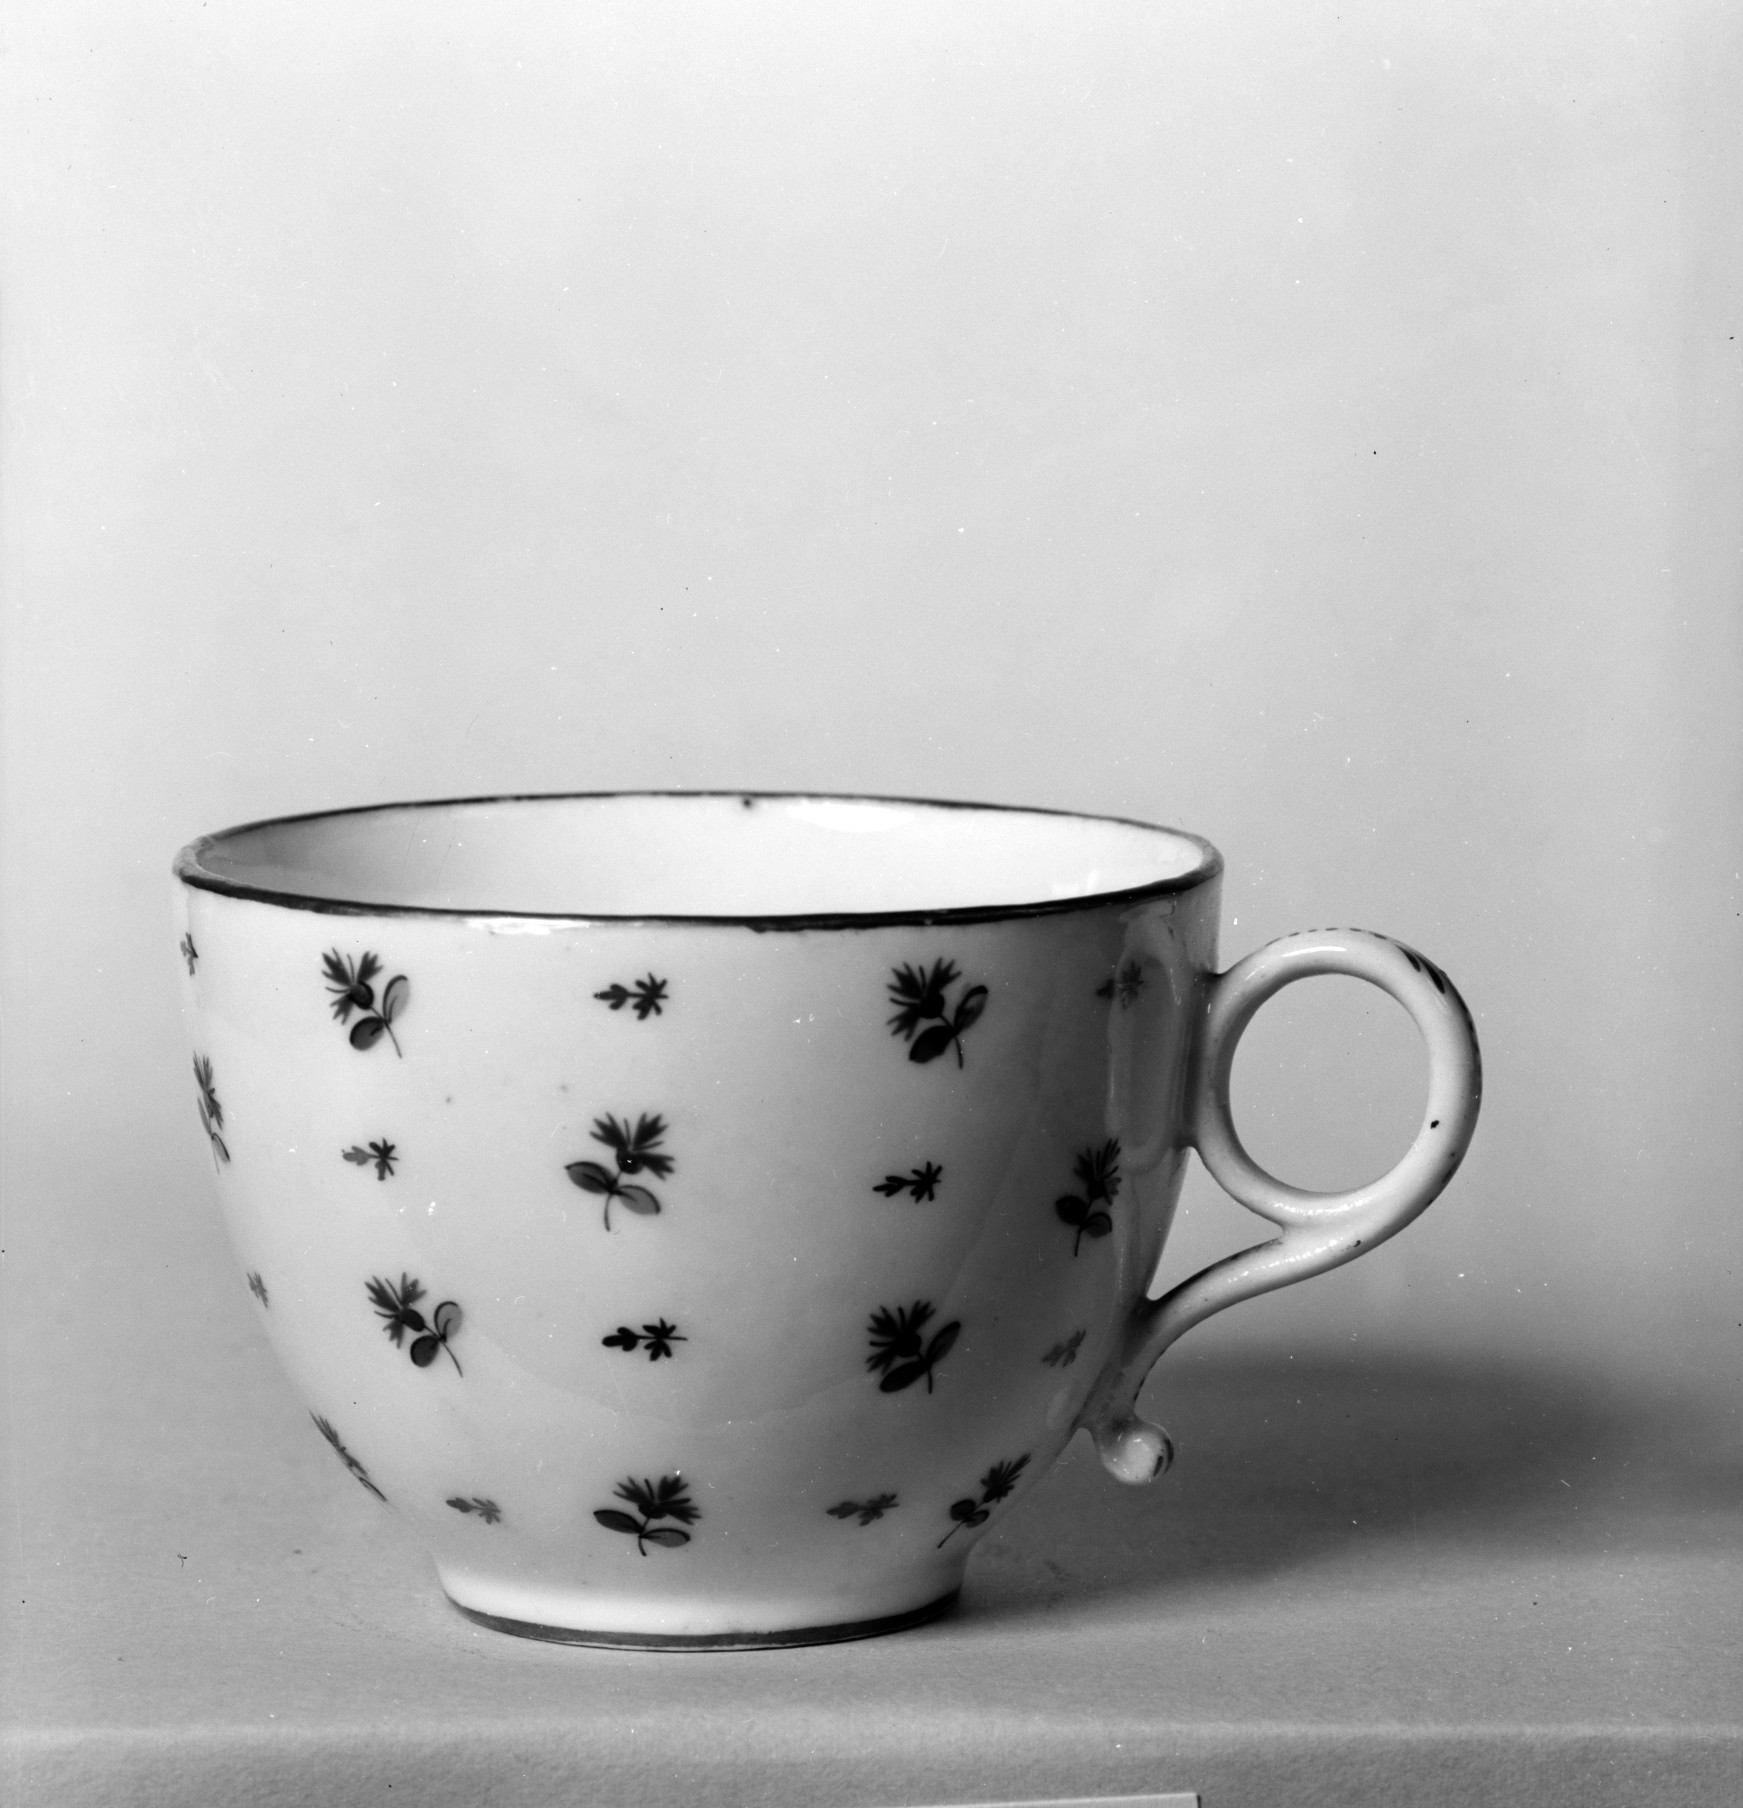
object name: cup and saucer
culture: french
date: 1780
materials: porcelain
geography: france